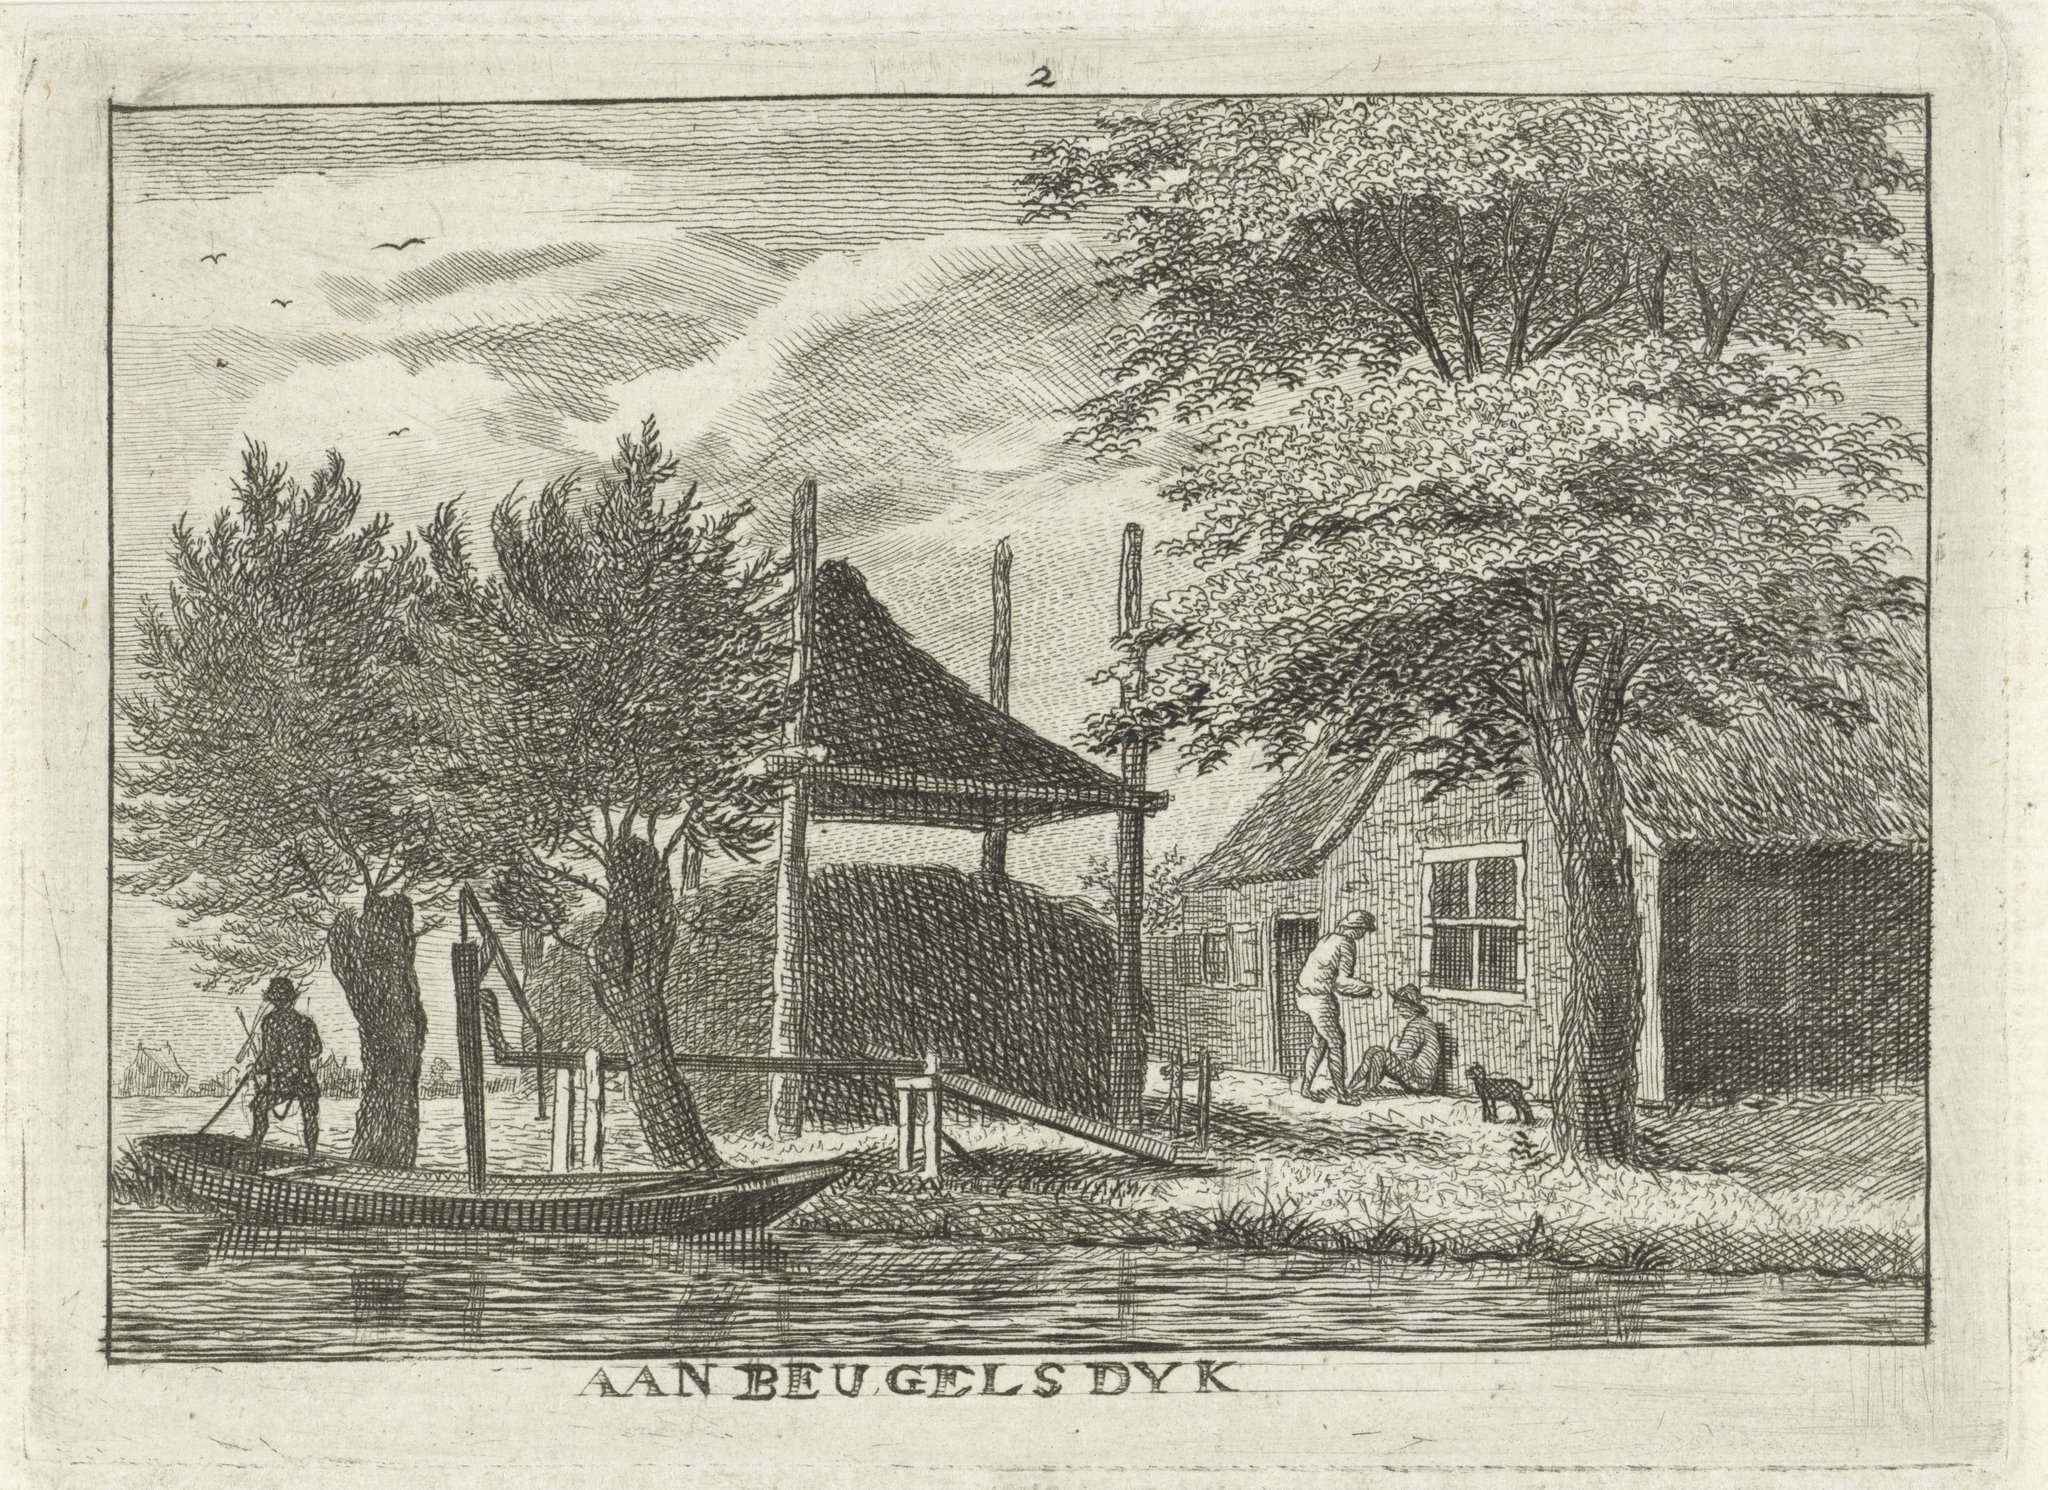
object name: print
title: Aan beugelsdyk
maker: hendrik roosing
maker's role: print maker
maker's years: 1763-1826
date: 1780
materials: paper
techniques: etching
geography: rotterdam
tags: canal, rowing-boat, canoe, etc., hay-stack, farm or solitary house in landscape, dog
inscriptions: collector's mark: Lugt 2228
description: Gezicht op een boerderij aan een vaart, met op de voorgrond een boot. Voor de boerderij twee figuren en een hond.